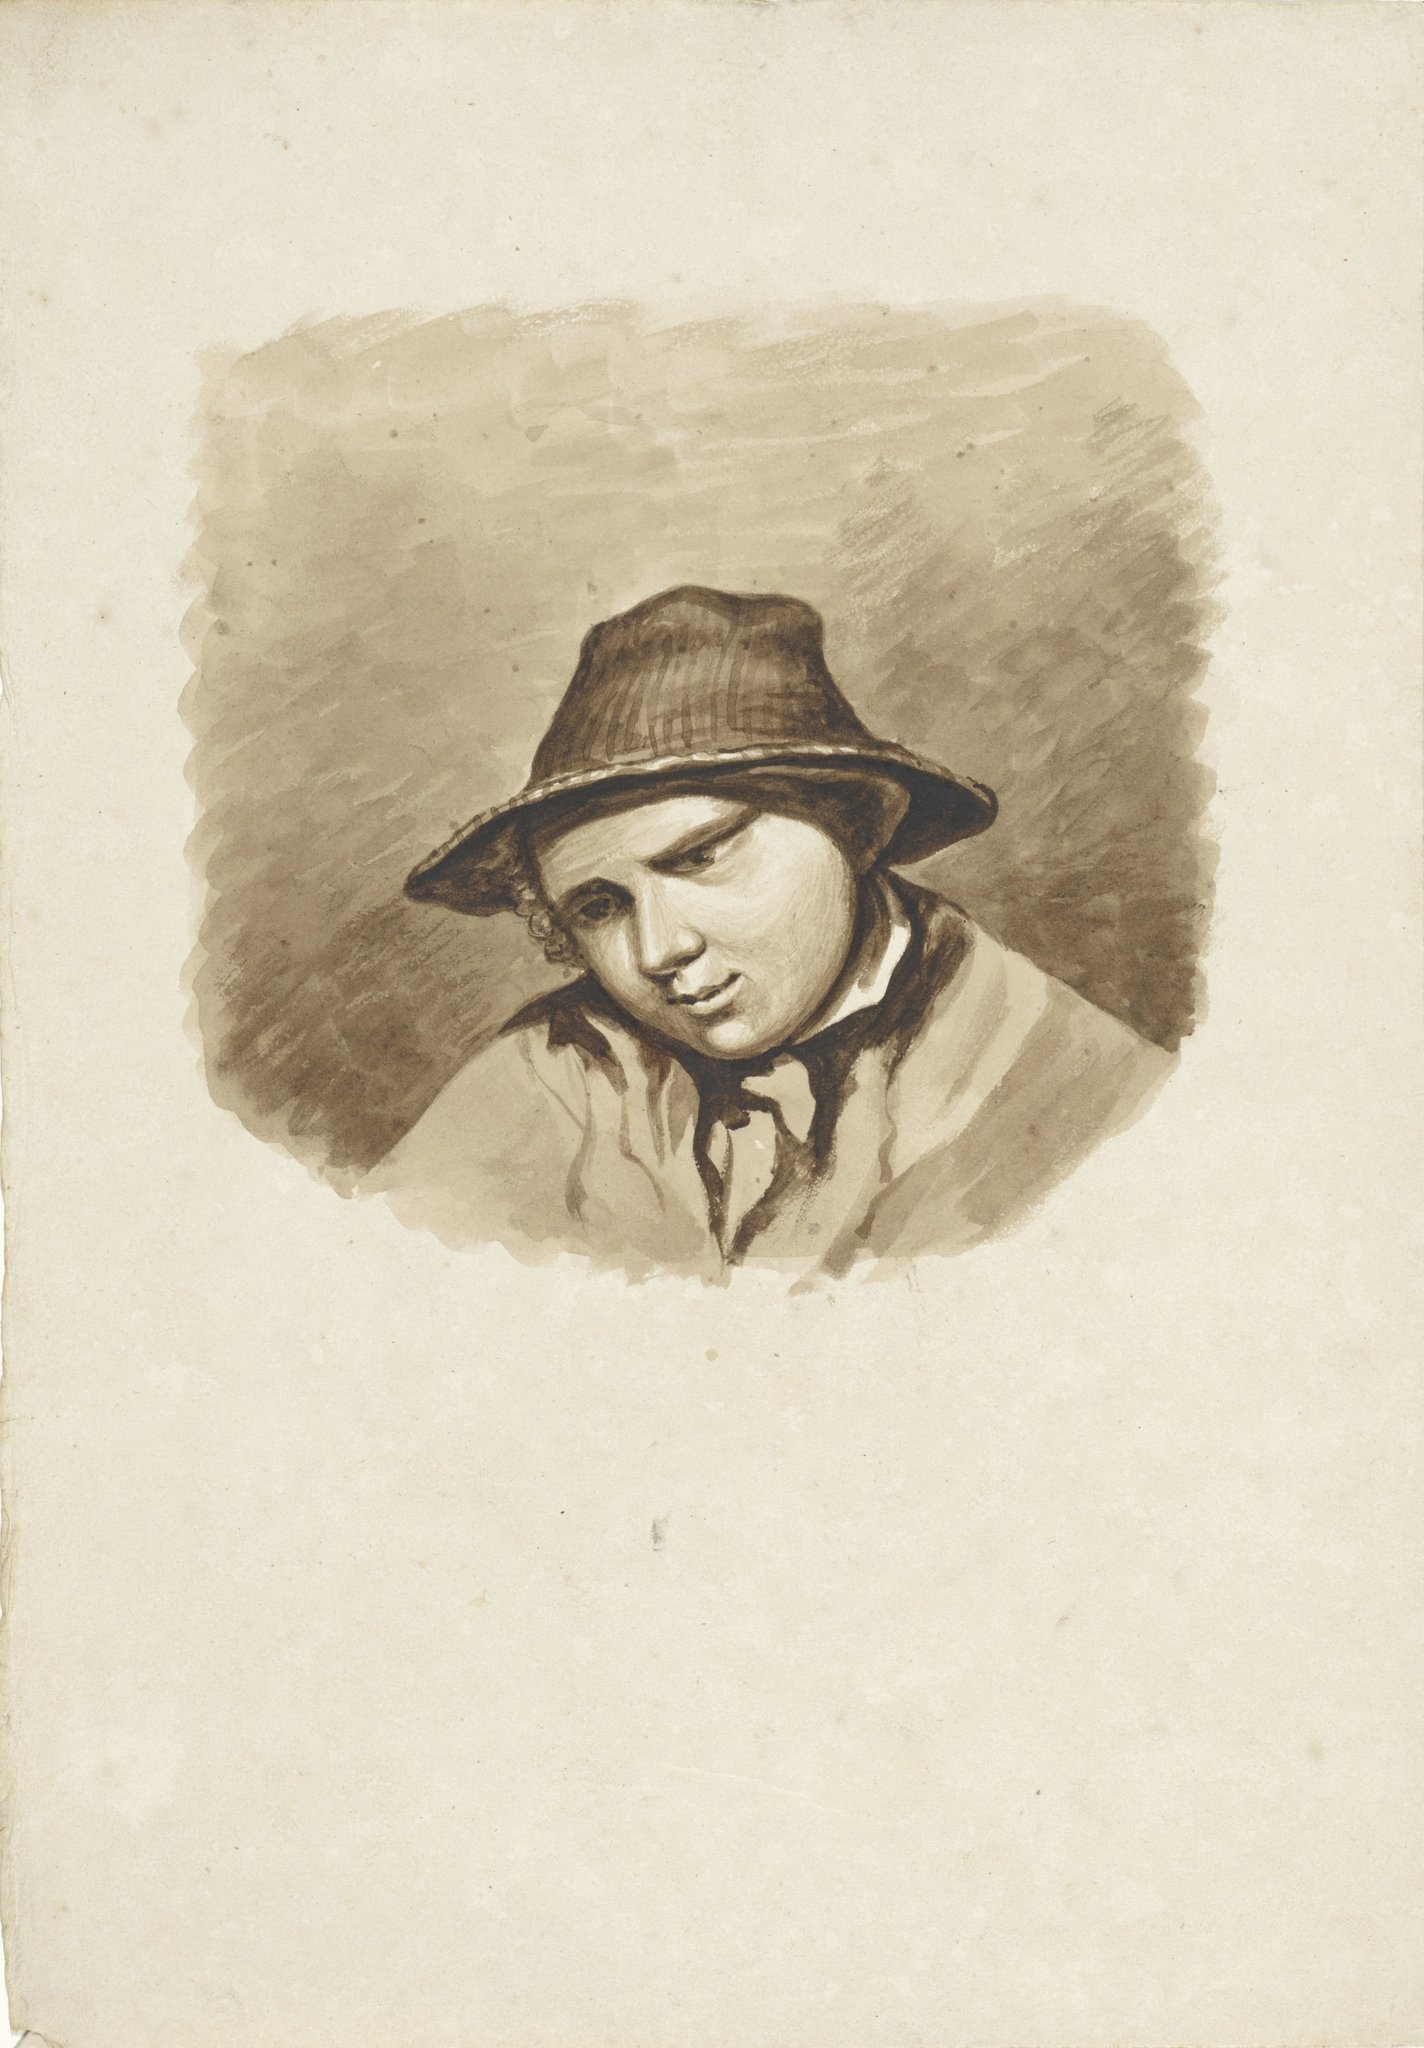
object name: drawing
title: Manskop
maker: pieter van loon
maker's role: draughtsman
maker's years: 1801-1873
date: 1811-1873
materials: paper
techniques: brush